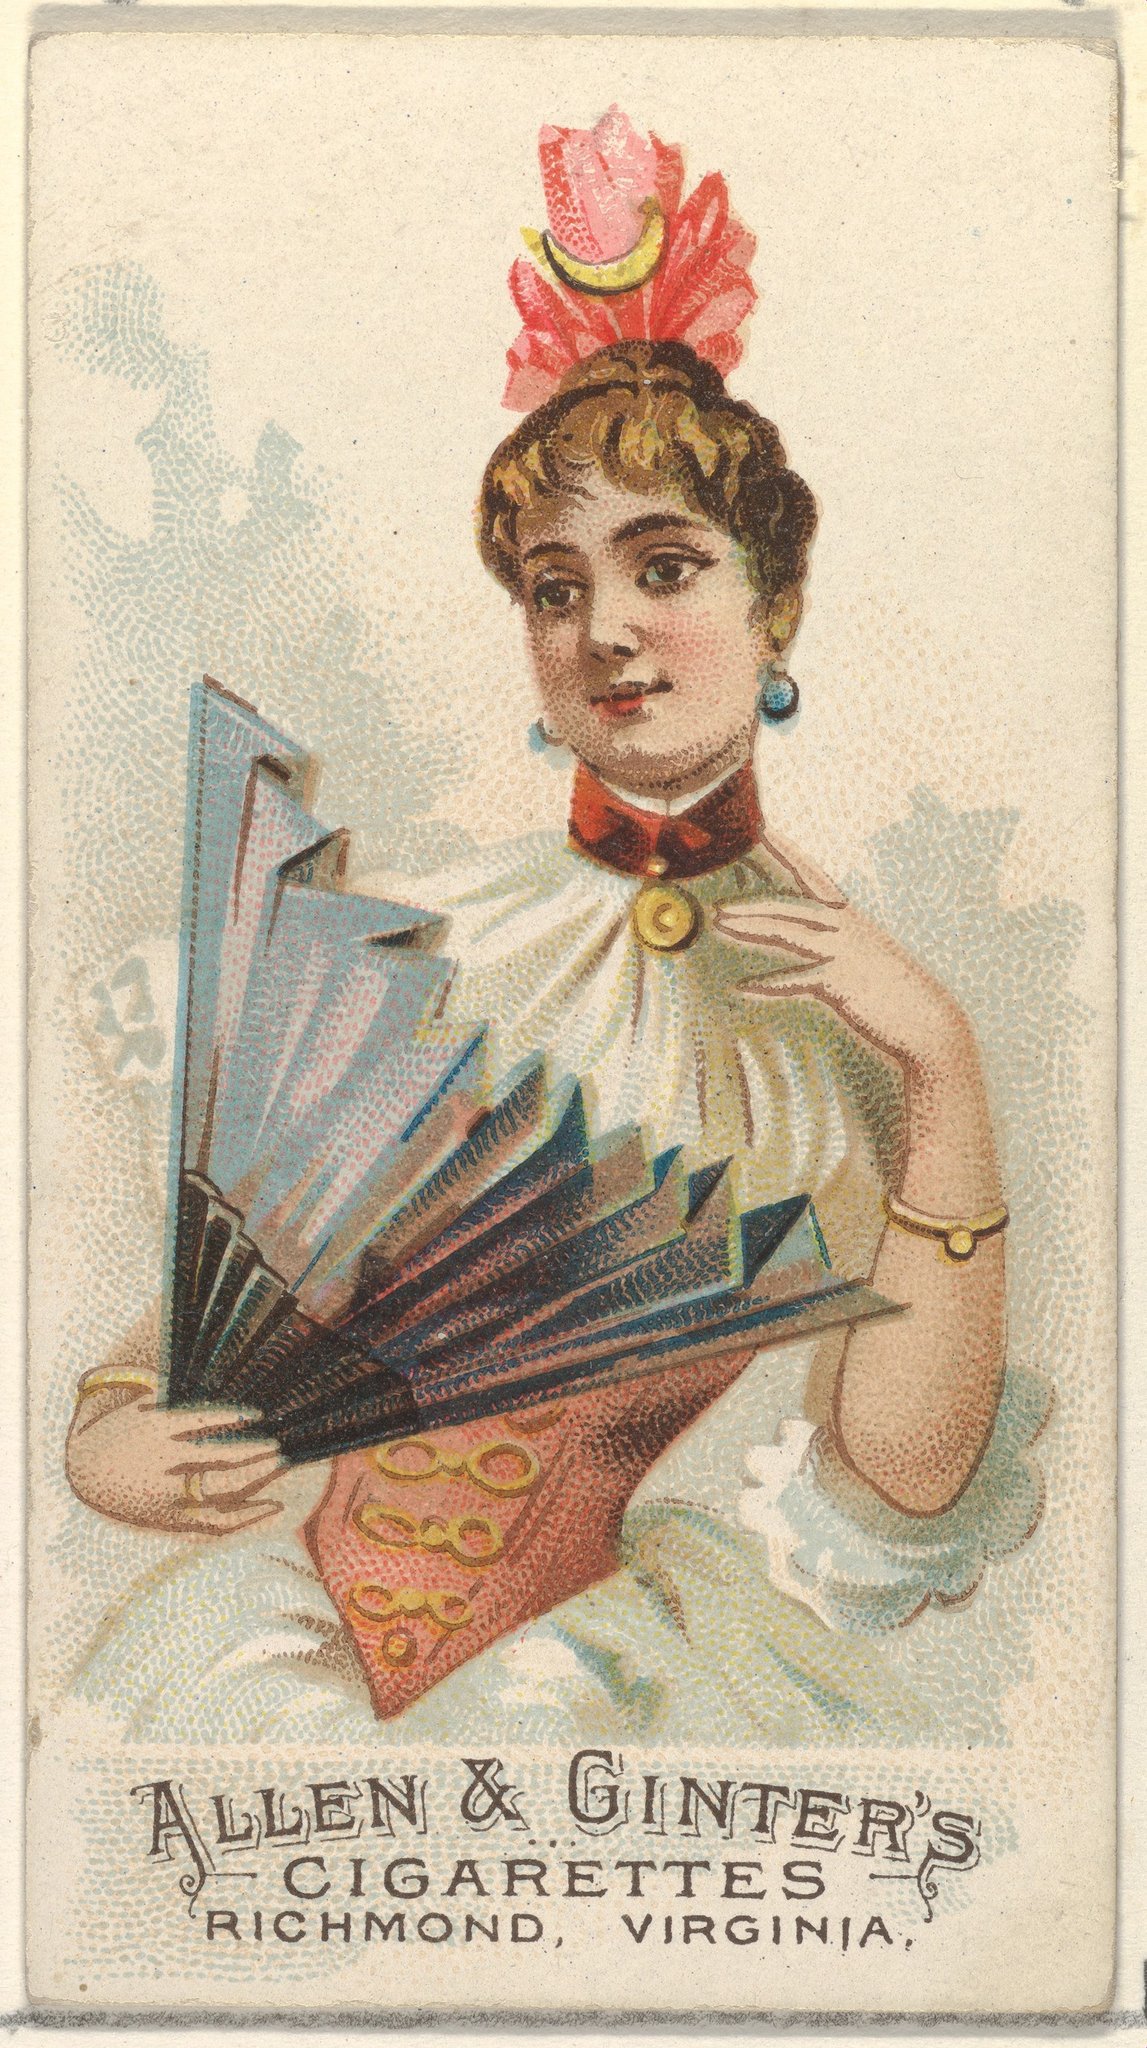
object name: print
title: Plate 35, from the Fans of the Period series (N7) for Allen & Ginter Cigarettes Brands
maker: allen & ginter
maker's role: publisher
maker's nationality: american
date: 1889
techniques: color lithograph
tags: fans,women